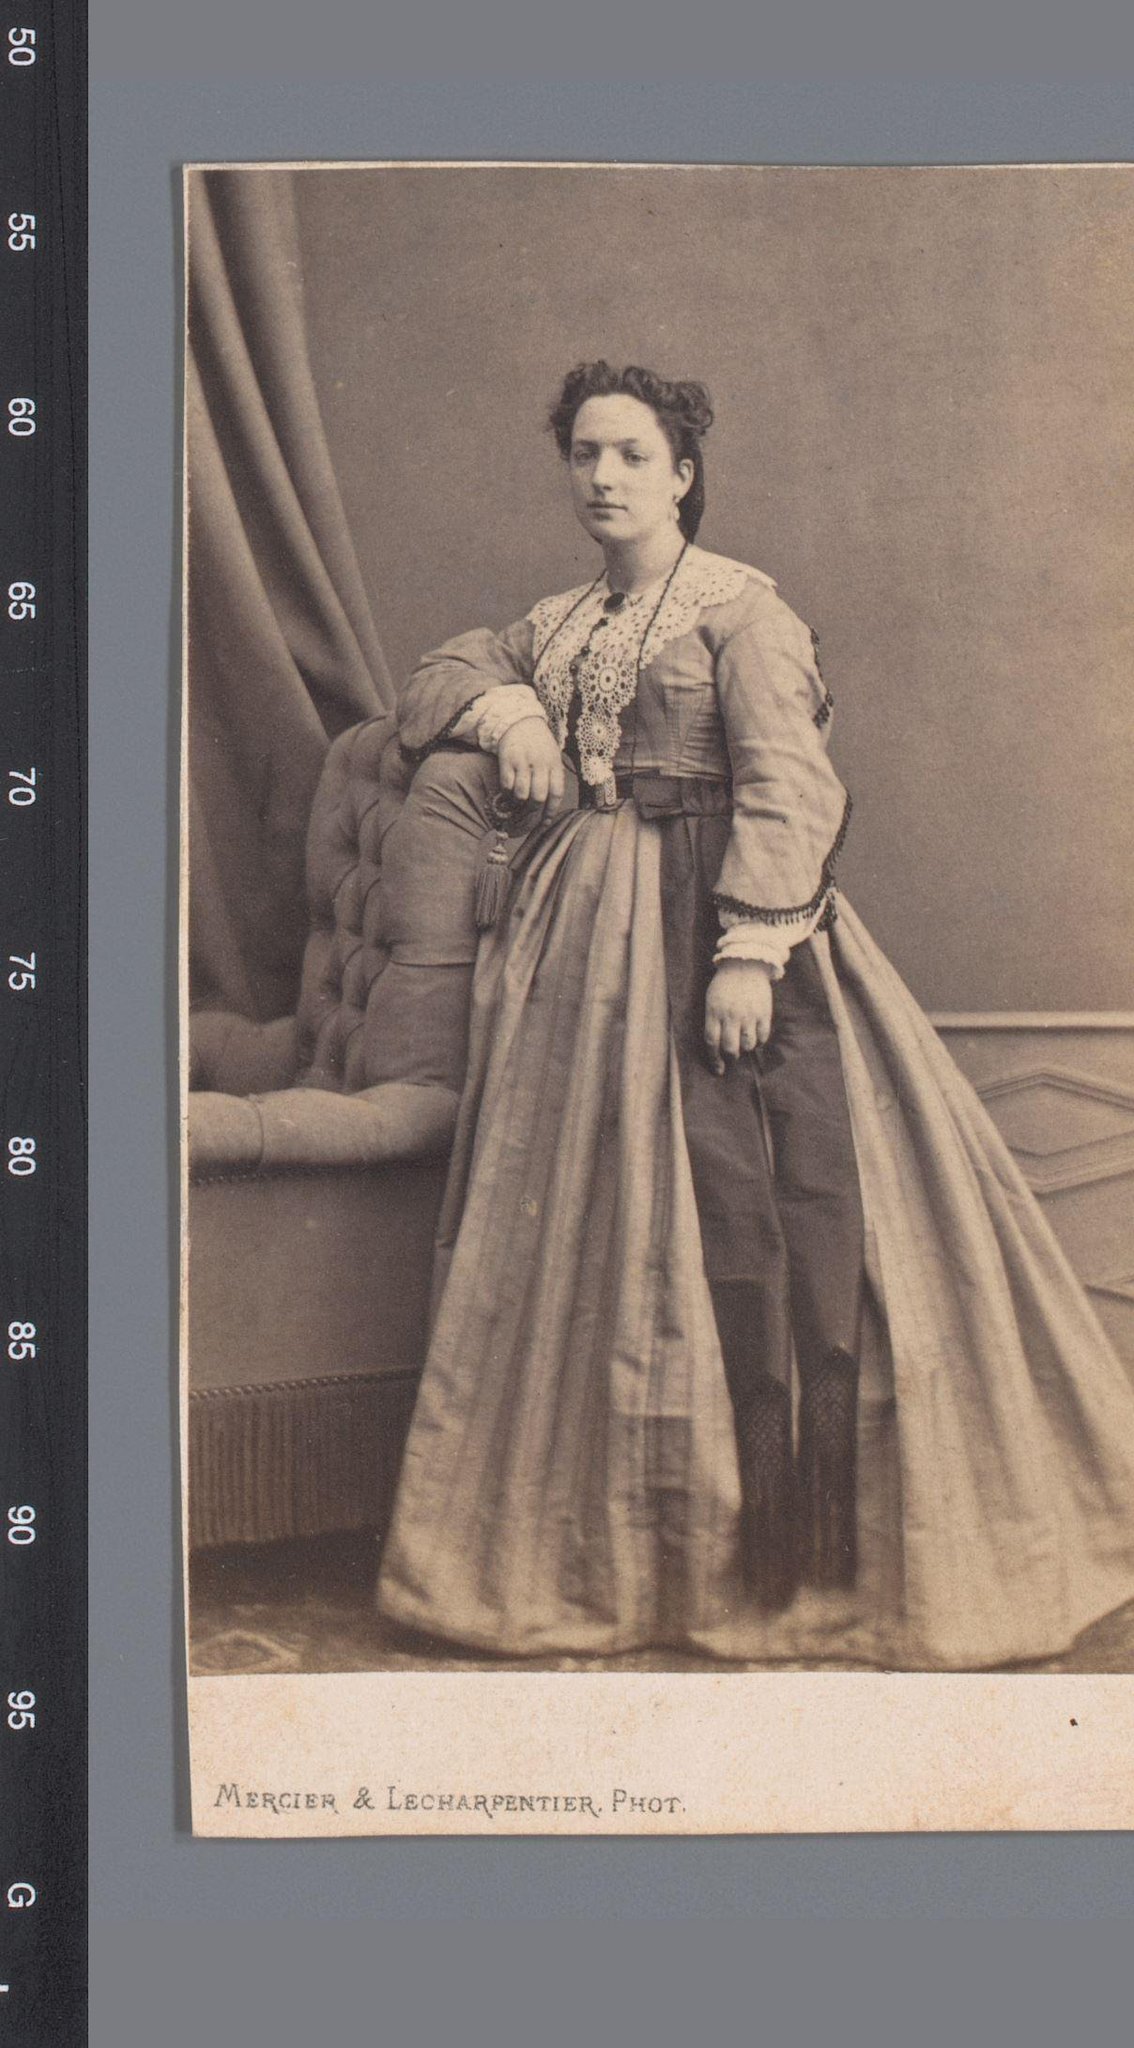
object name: carte de visite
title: Portret van een onbekende vrouw bij een fauteuil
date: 1855-1885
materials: cardboard, paper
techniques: albumen print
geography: paris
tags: adult woman, anonymous historical person portrayed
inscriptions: address: ‘Rue de la Grande Truanderie prolongée, 2/ AU COIN DU BOULEVd DE SÉBASTOPOL/ en face l'Eglise St Leu/ Paris.’, inscription: ‘ART & INDUSTRIE PHOTOGRAPHIQUES’